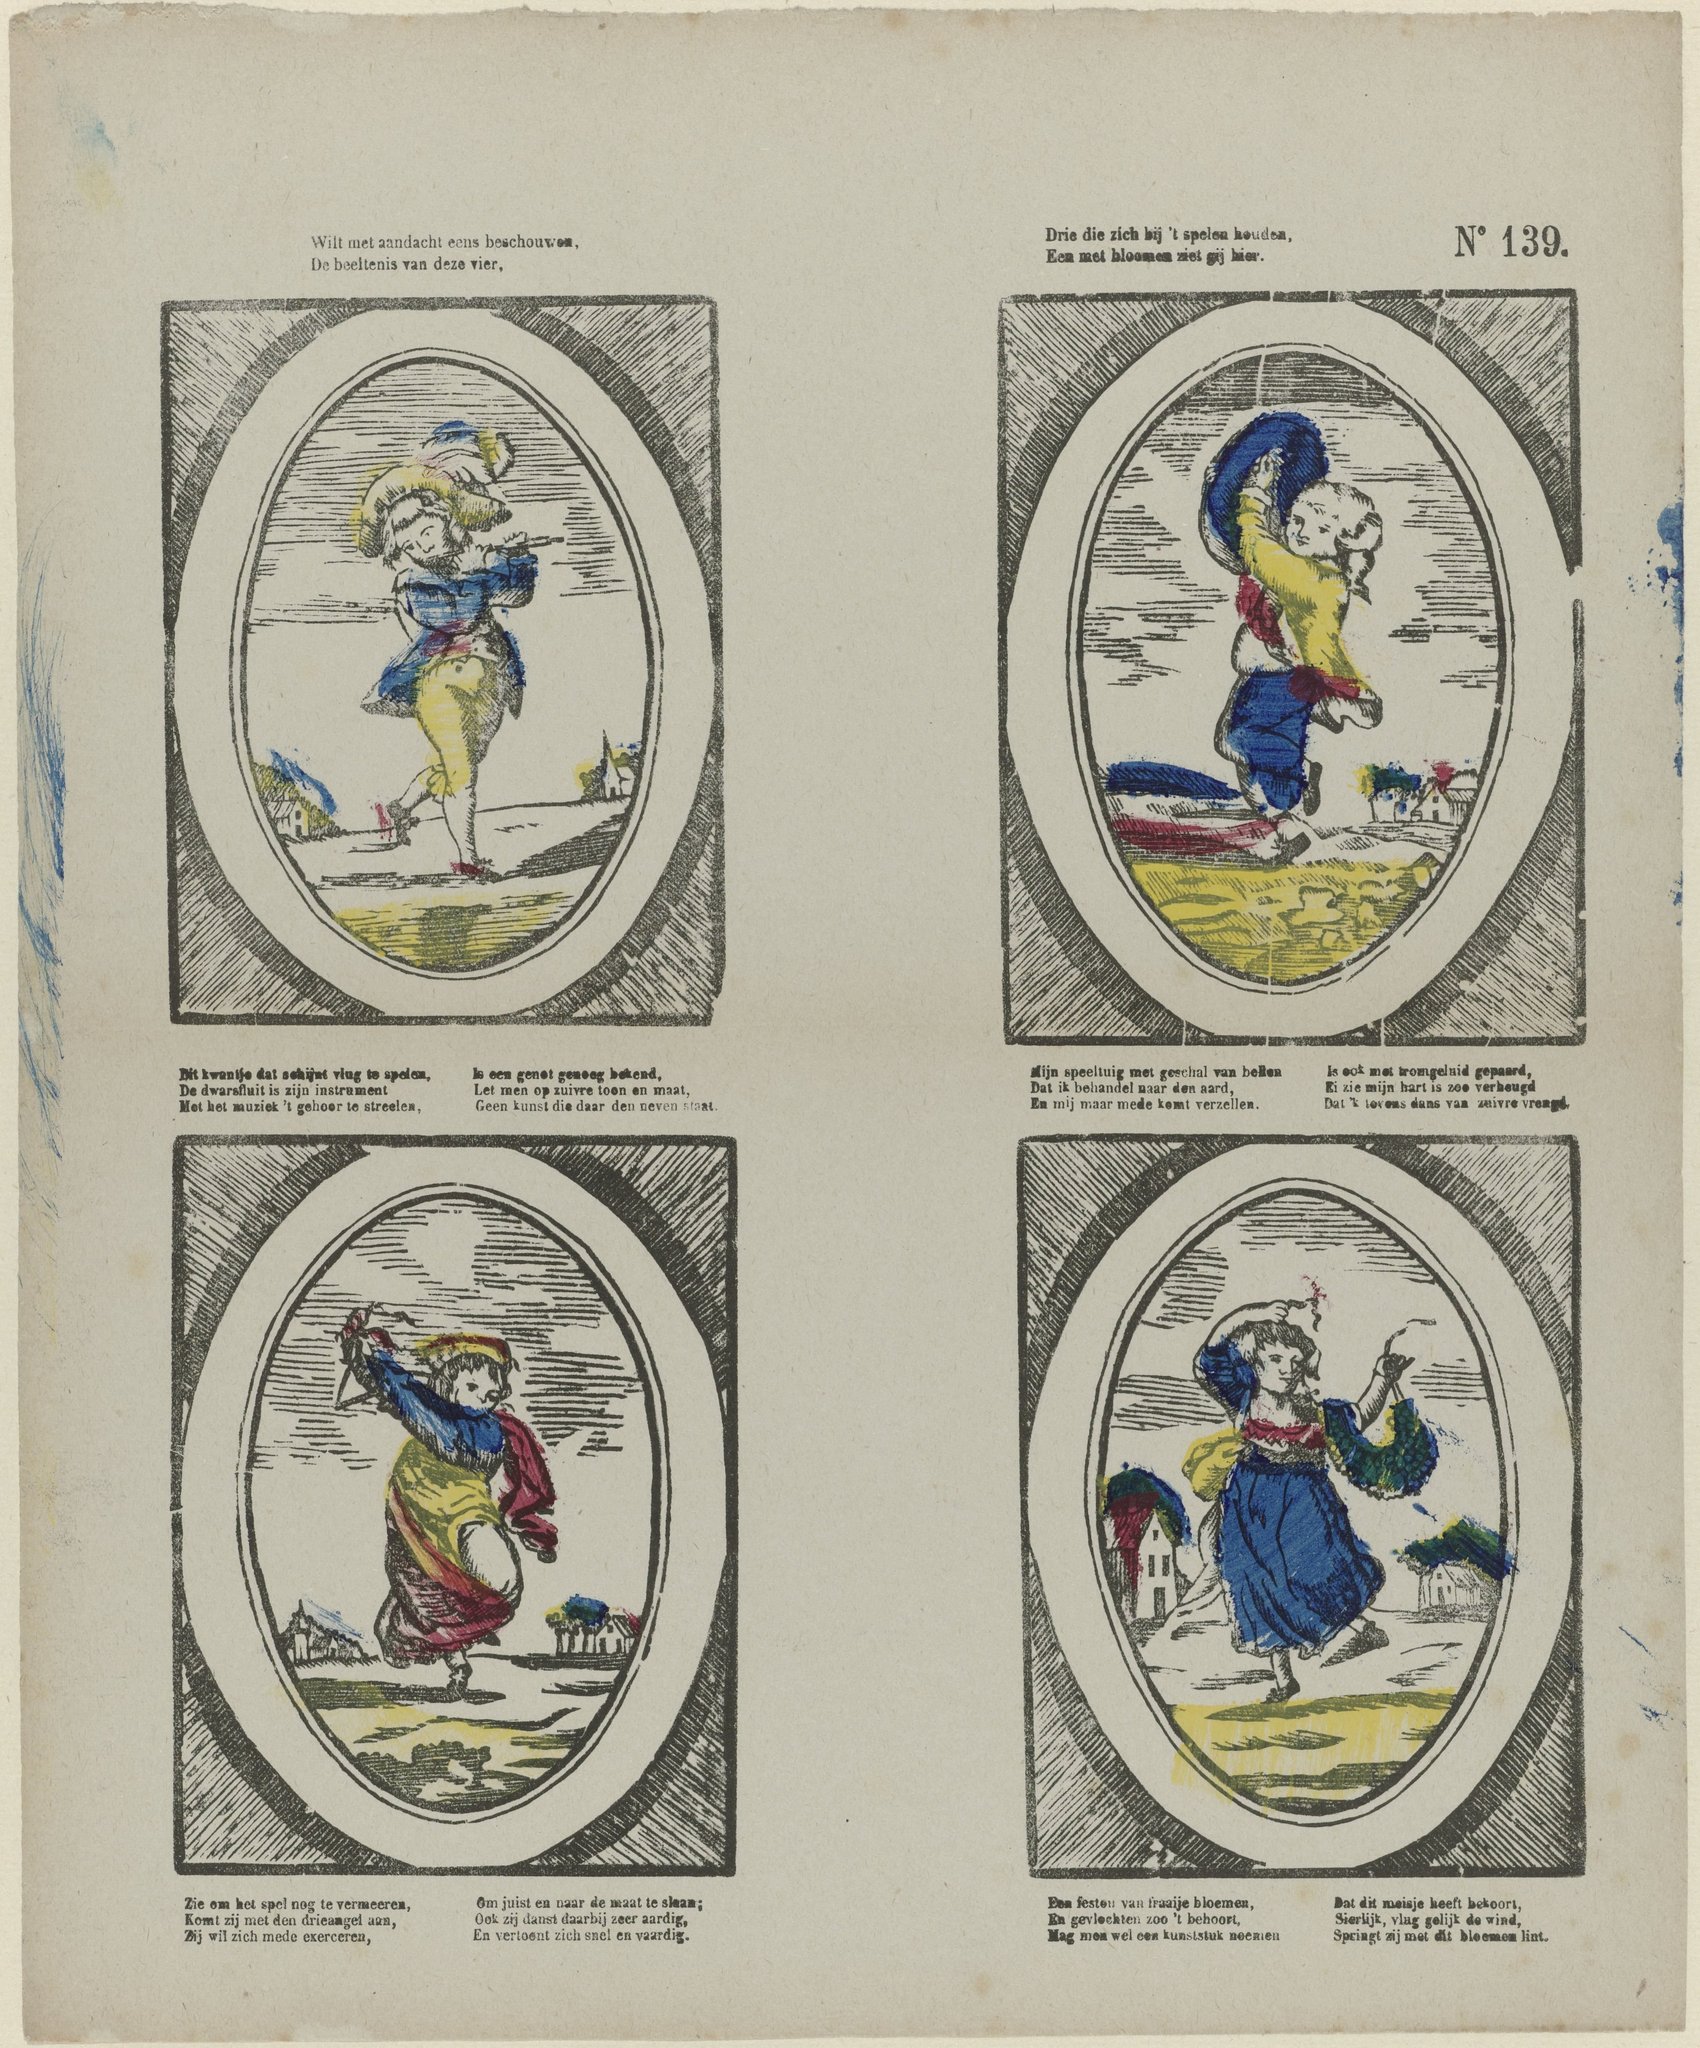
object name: print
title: Wilt met aandacht eens beschouwen, / De beeltenis van deze vier, / Drie die zich bij 't spelen houden, / Een met bloemen ziet gij hier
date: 1827-1894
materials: paper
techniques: colour, letterpress printing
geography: schaarbeek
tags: making music; musician with instrument, dancing, child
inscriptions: collector's mark: Lugt 2760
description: Blad met 4 voorstellingen van dansende en musicerende kinderen, gevat in ovale lijsten. Onder elke afbeelding een zesregelig vers in twee kolommen. Genummerd rechtsboven: No 139.